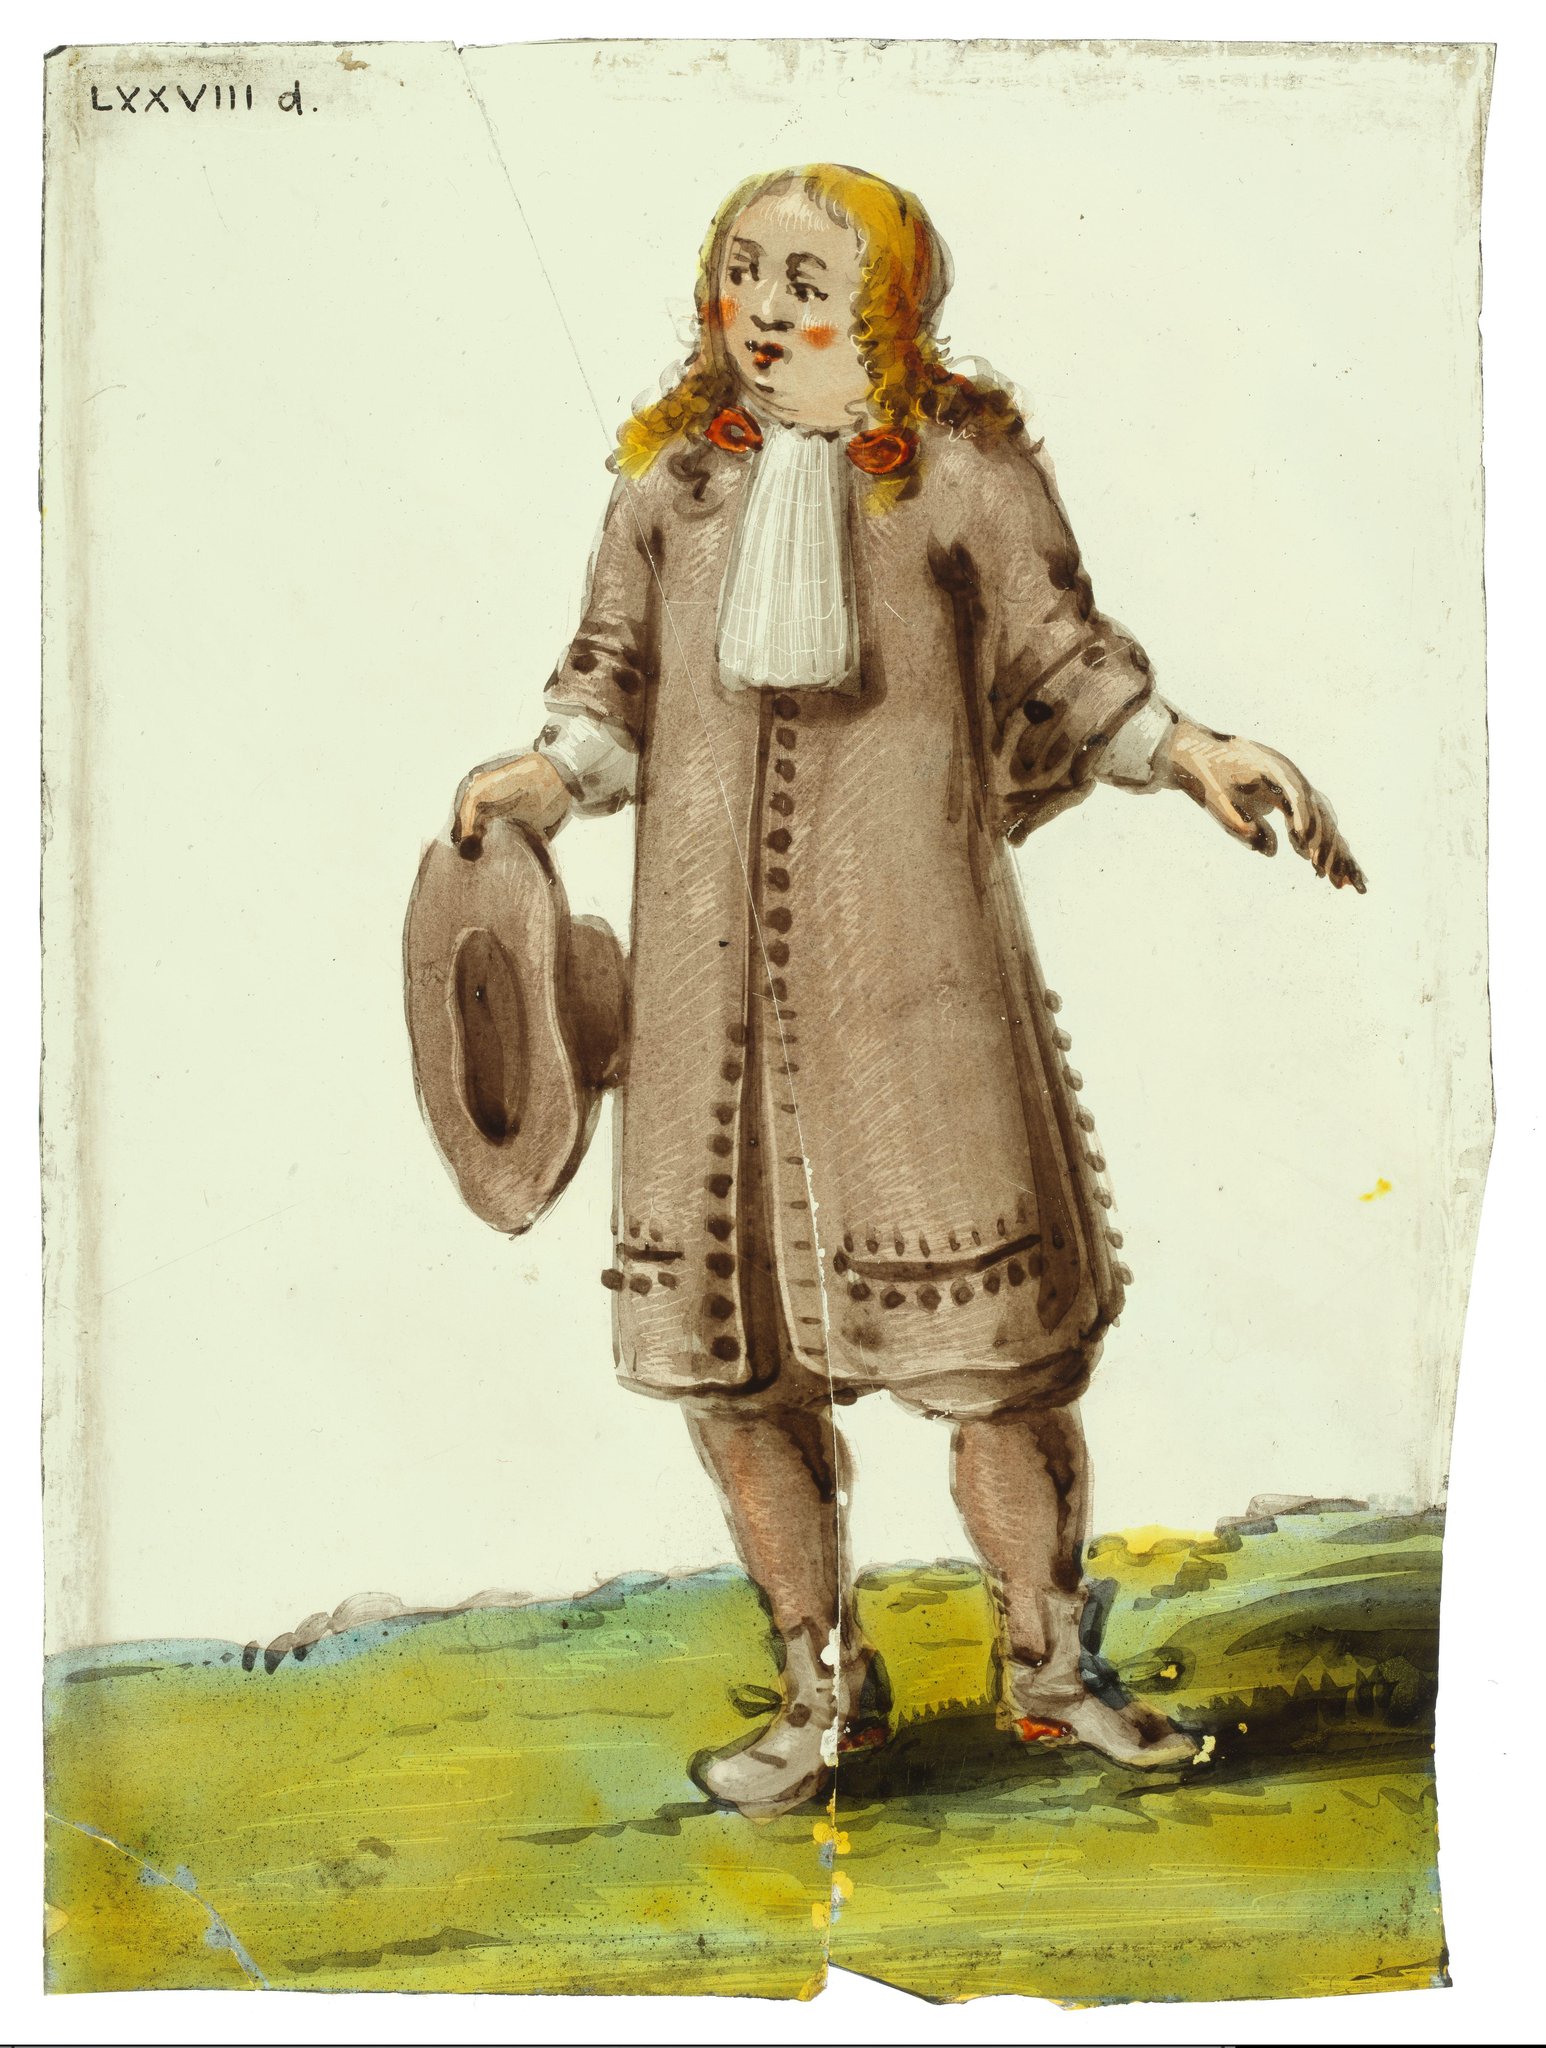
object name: light window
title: Ruit met een man met hoed in de hand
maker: Anonymous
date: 1650-1675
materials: glass, lead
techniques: enamel painting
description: Een ruit met emailschildering van een man, een predikant of geleerde, met de hoed in de hand, gekleurd.